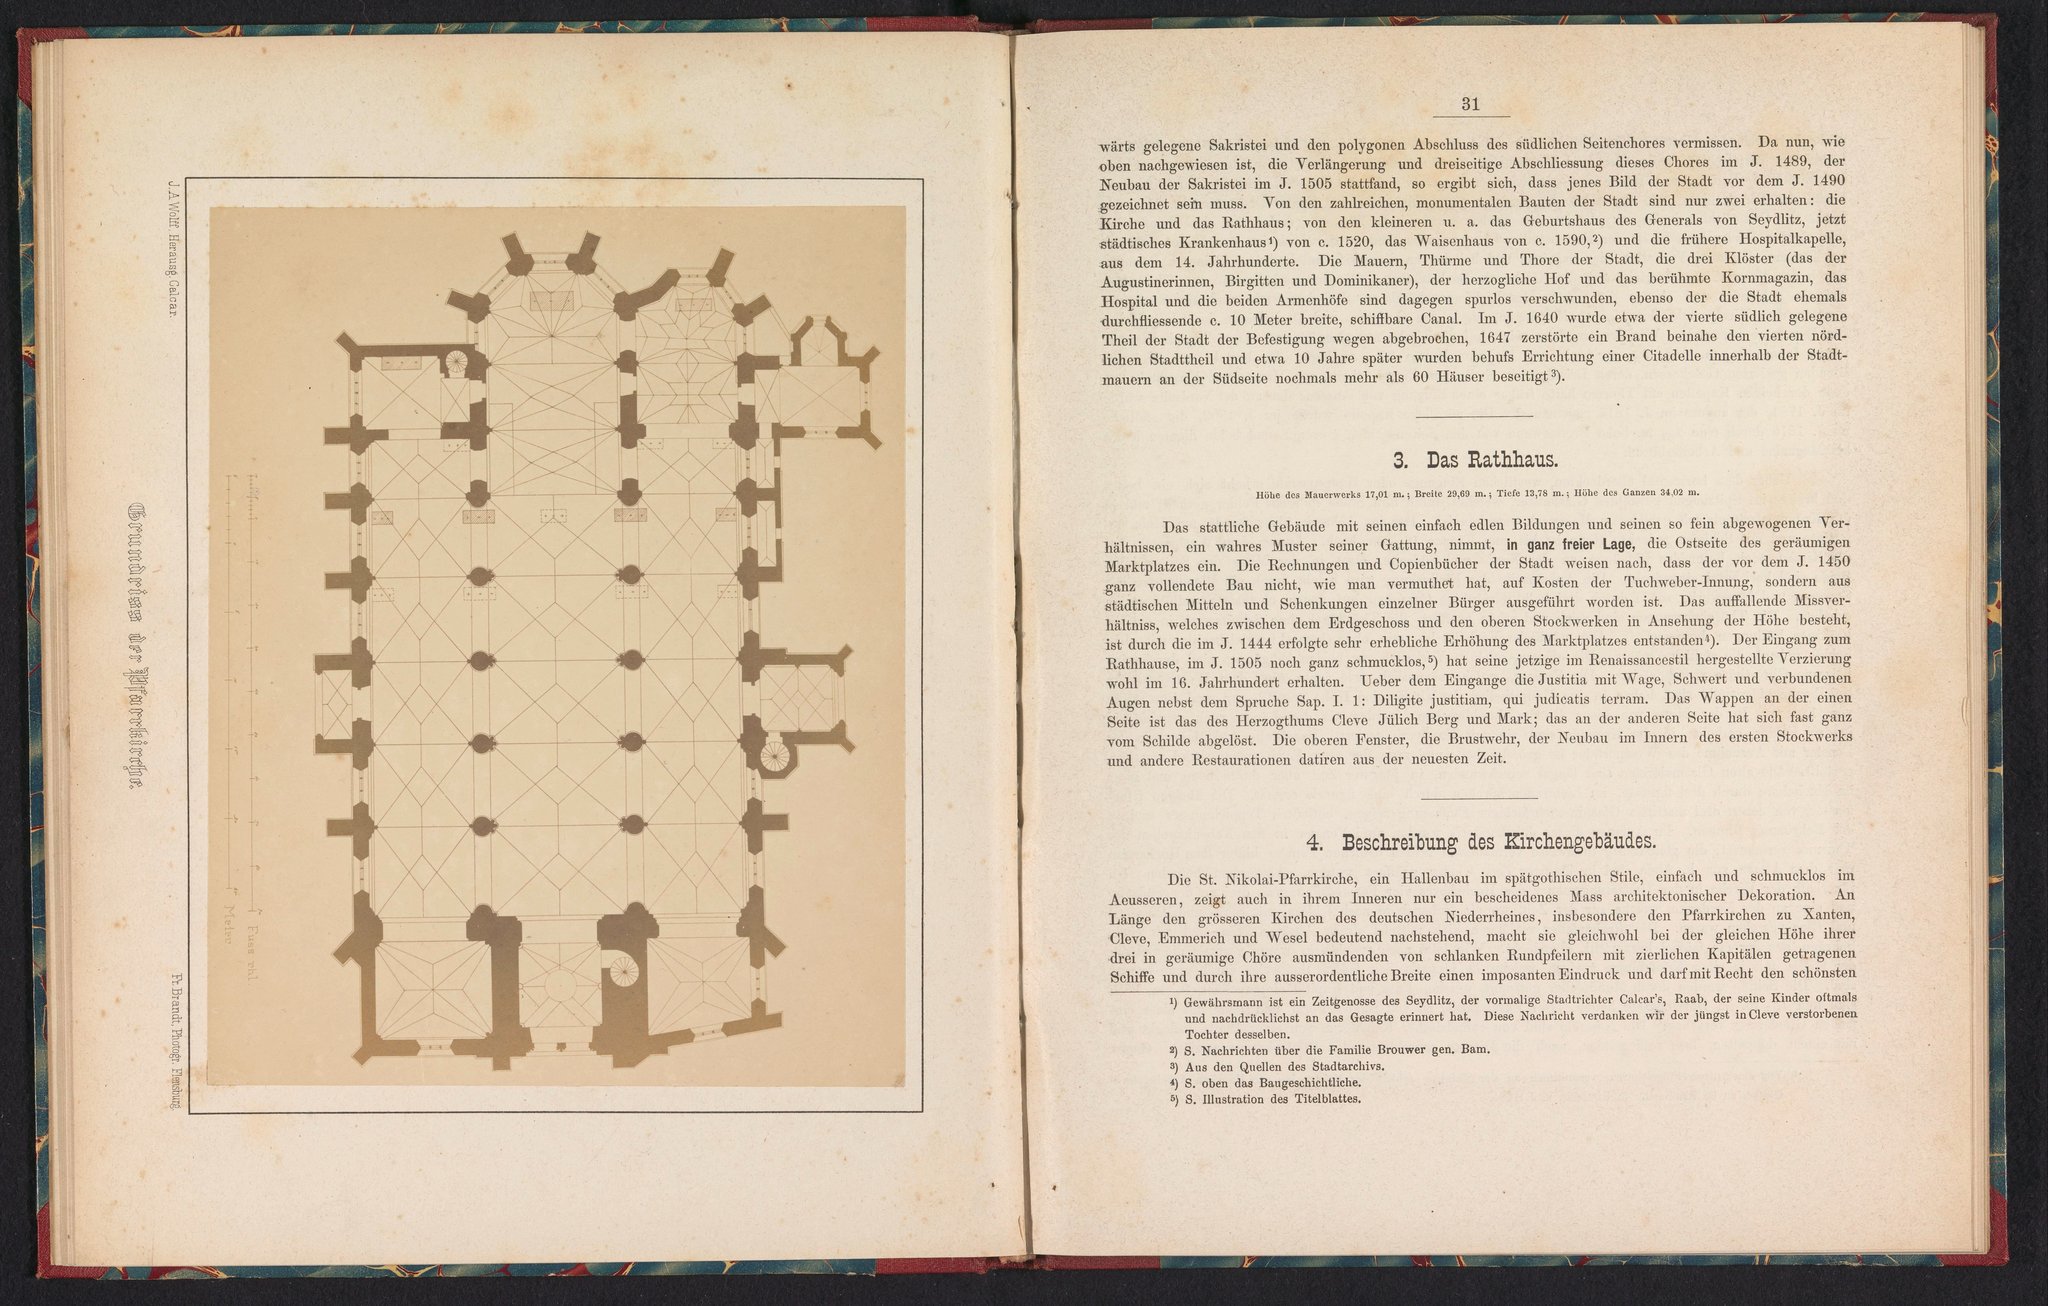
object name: page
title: Grundriss der Pfarrkirche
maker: friedrich brandt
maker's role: fotograaf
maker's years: 1823-1891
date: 1870-1880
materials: photographic support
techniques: albumen print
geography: kalkar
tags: the christian churches, drawing, sketch